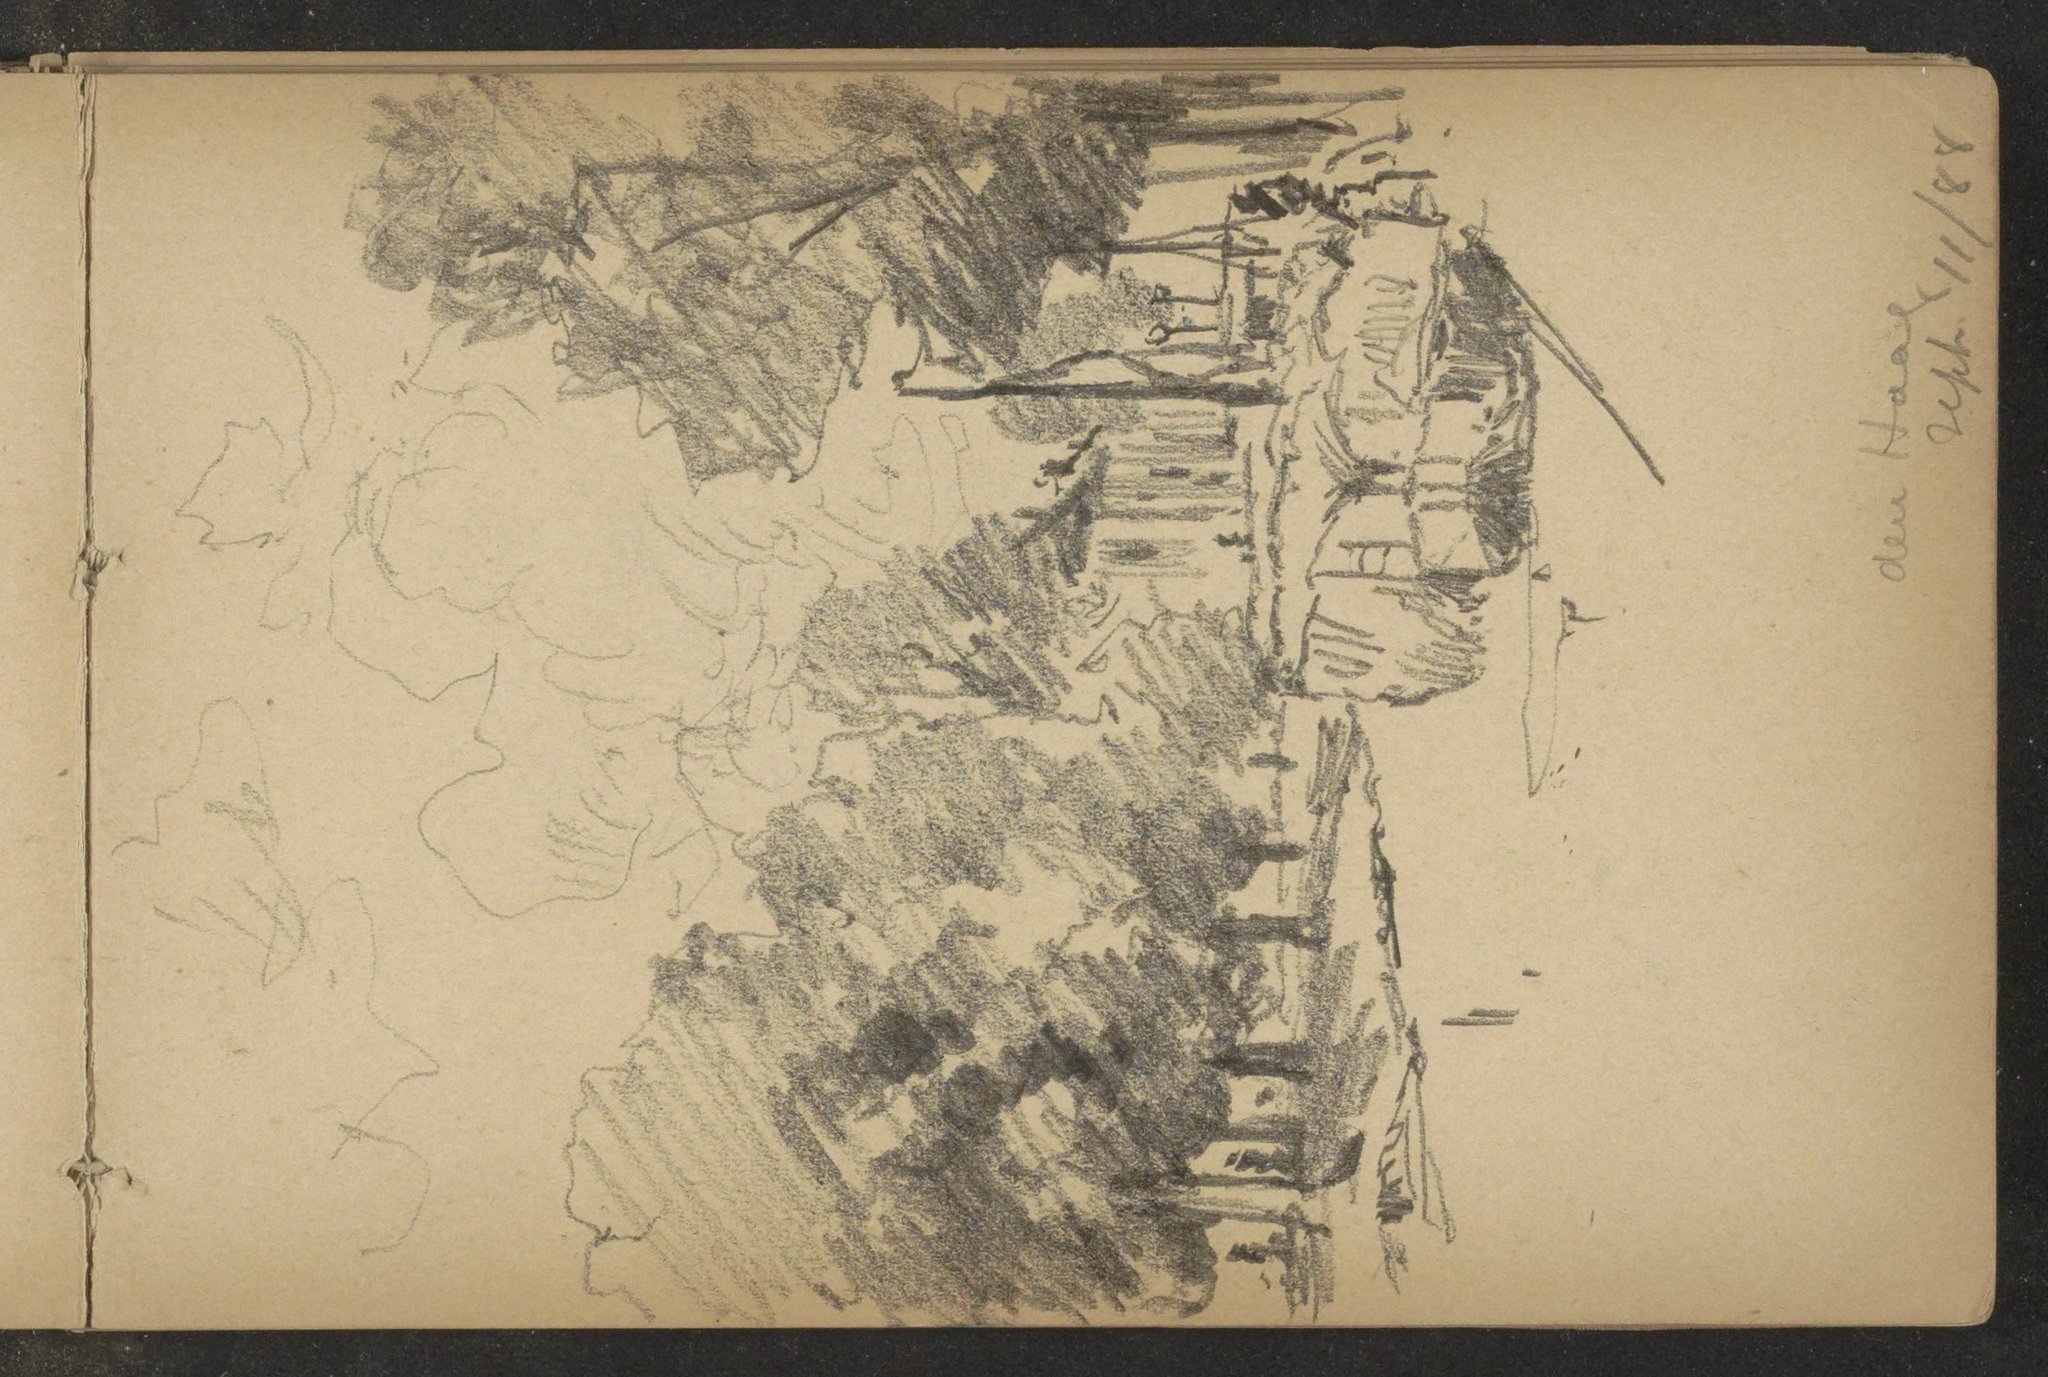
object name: sketchbook leaf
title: Gezicht op een kade te Den Haag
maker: alexander shilling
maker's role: draughtsman, print maker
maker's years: 1859-1937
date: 1809-1888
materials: paper, pencil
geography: the hague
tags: sailing-ship, sailing-boat, canals, waters (in city), the hague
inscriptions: date and inscription: ‘den Haag/ sept 11/88’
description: Blad 12 recto uit een schetsboek met 34 bladen.